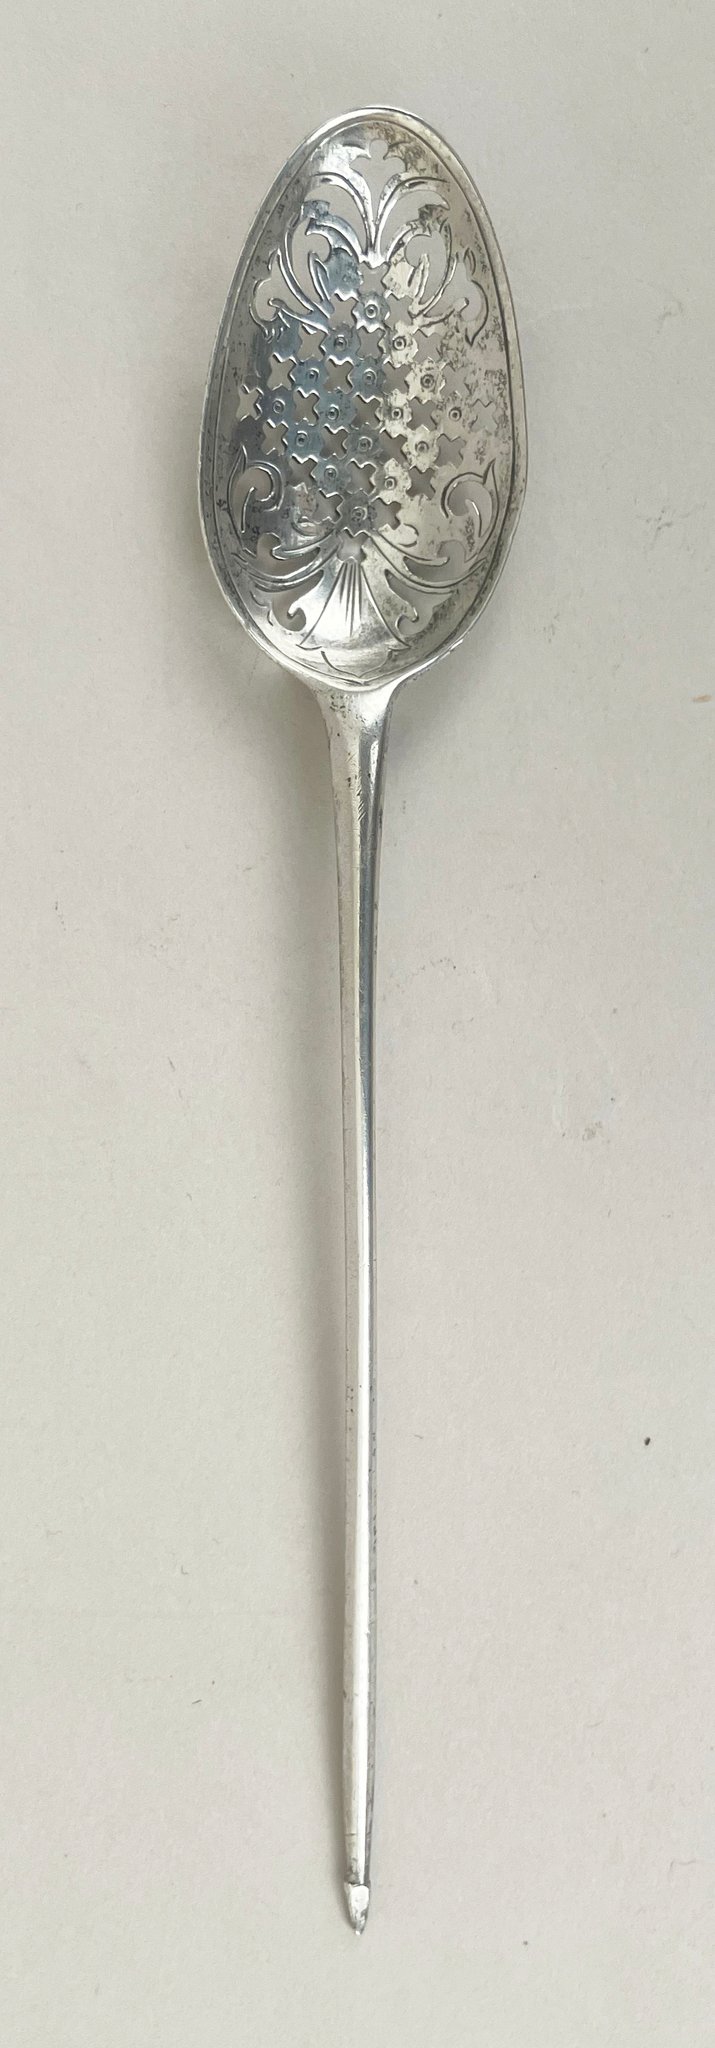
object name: strainer spoon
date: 1701-1800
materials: silver